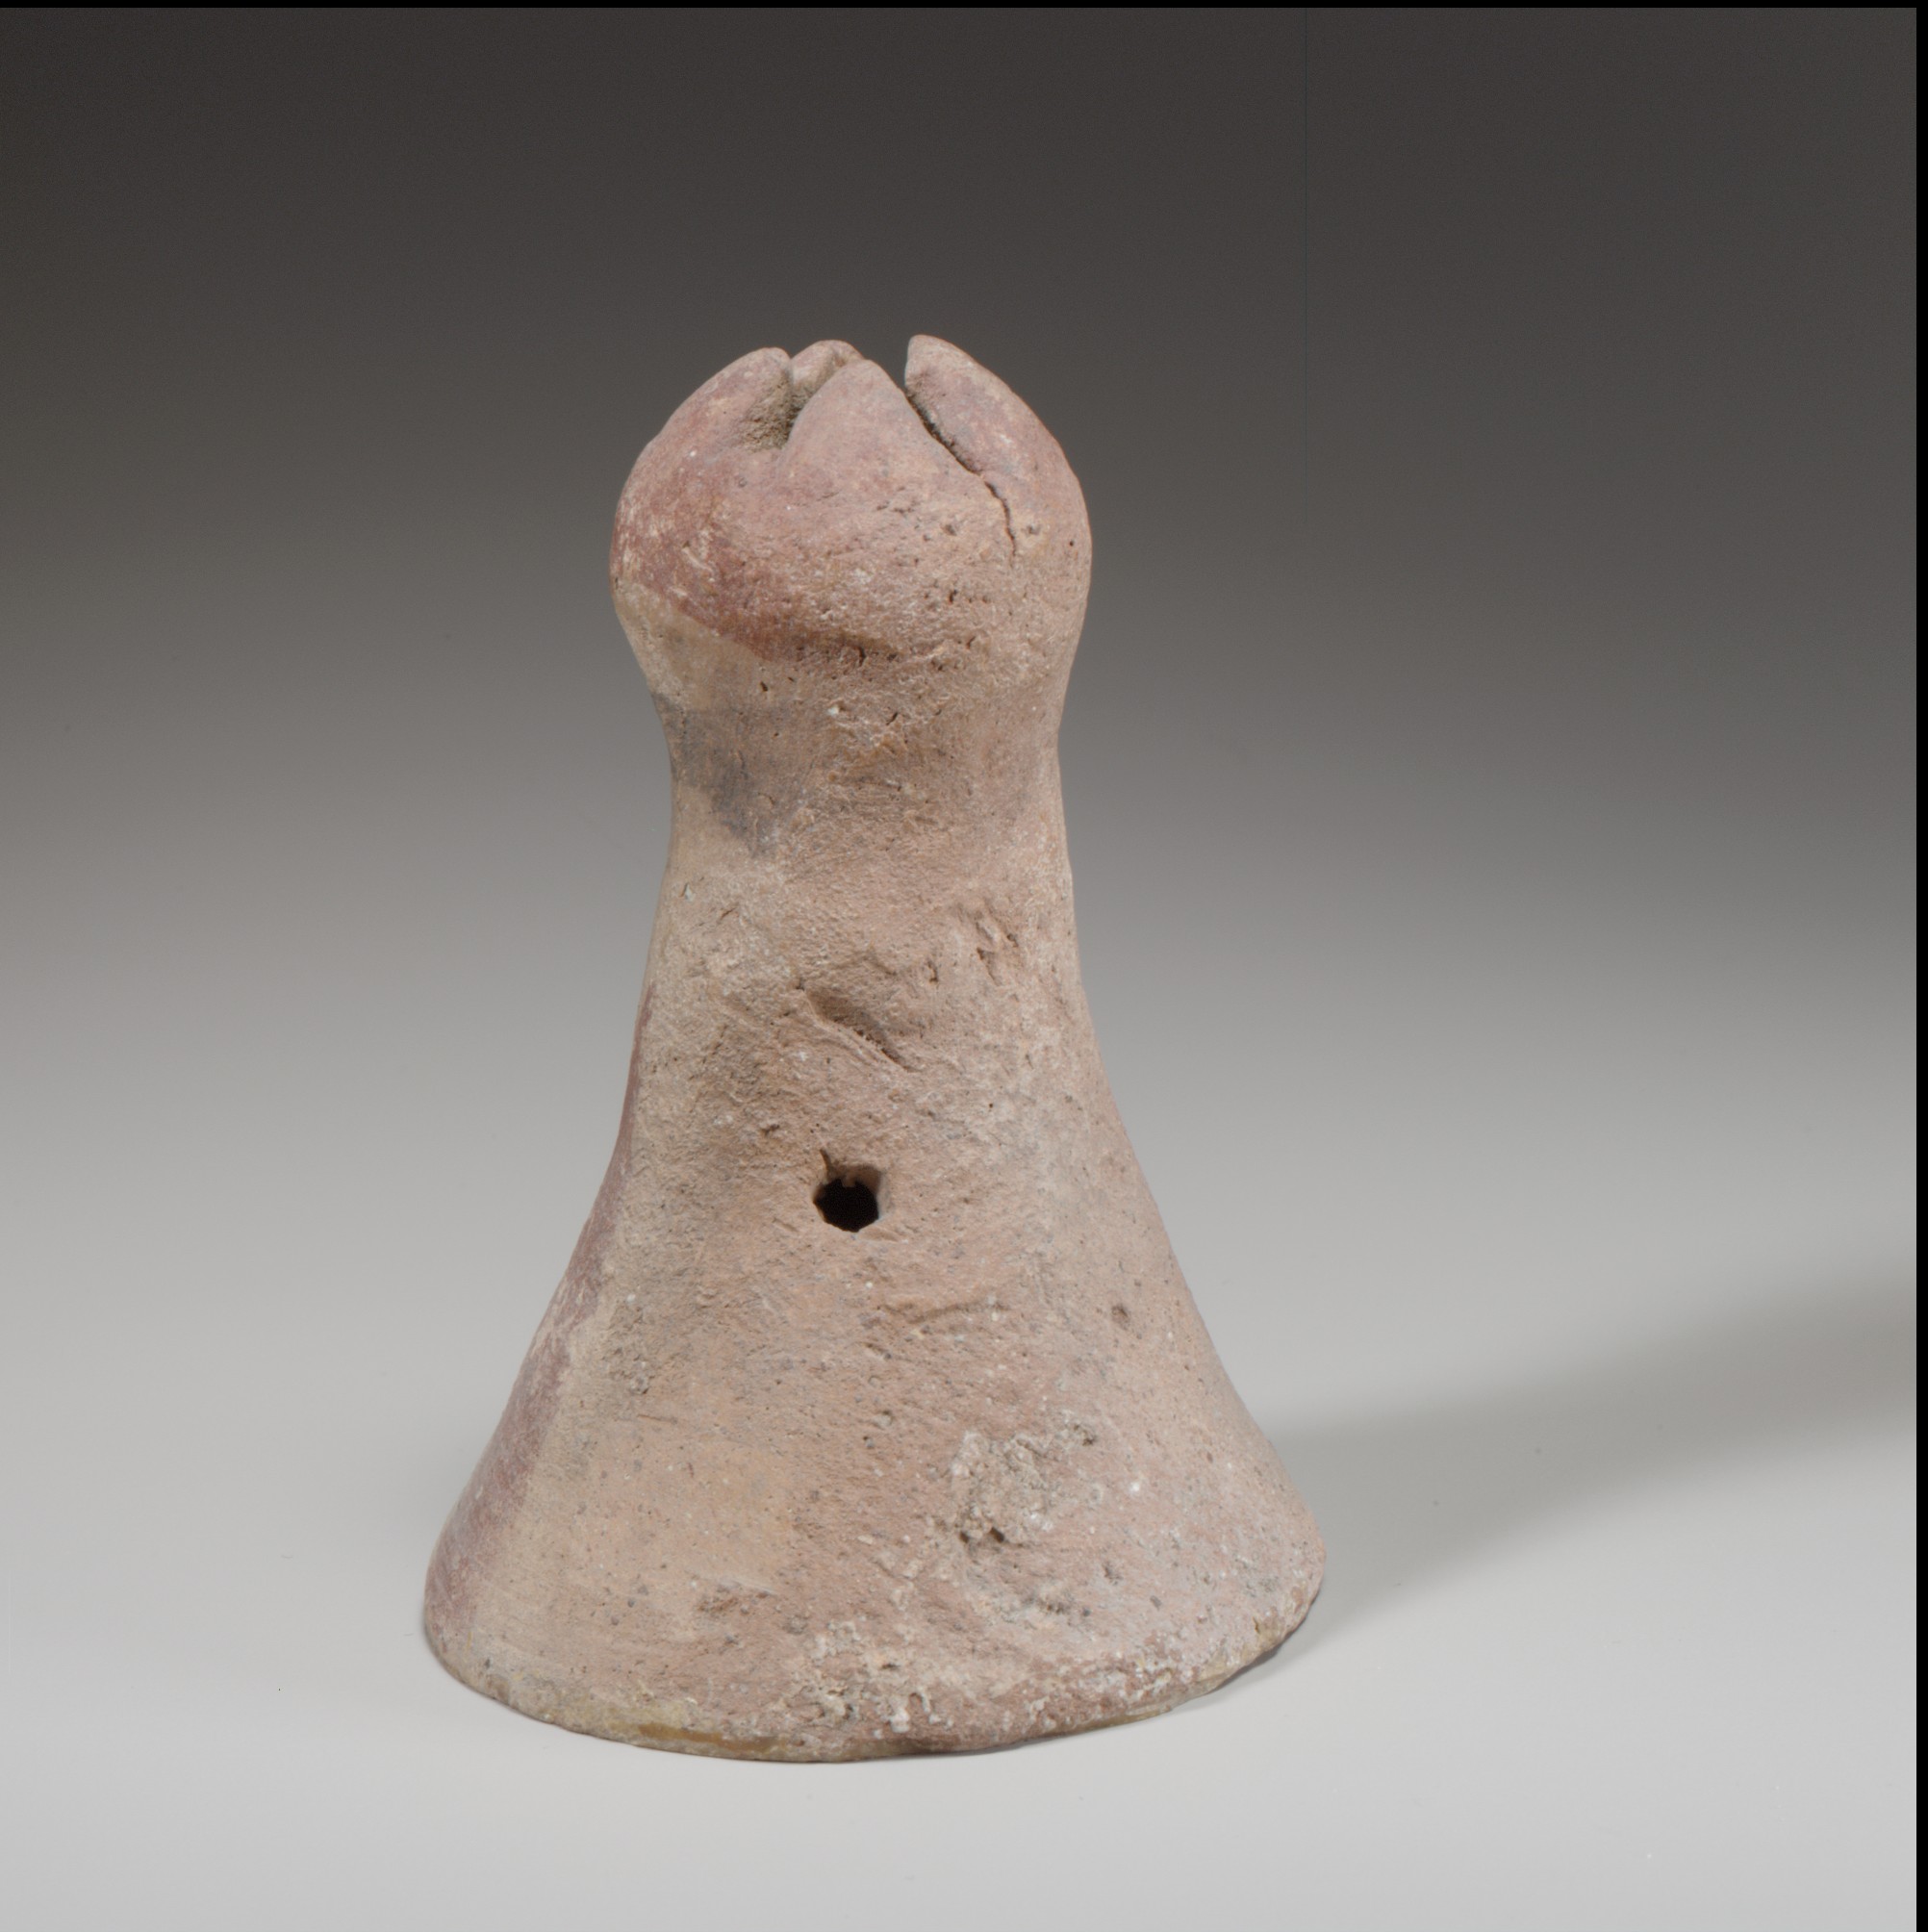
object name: bell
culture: cypriot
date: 600-480 BCE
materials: terracotta